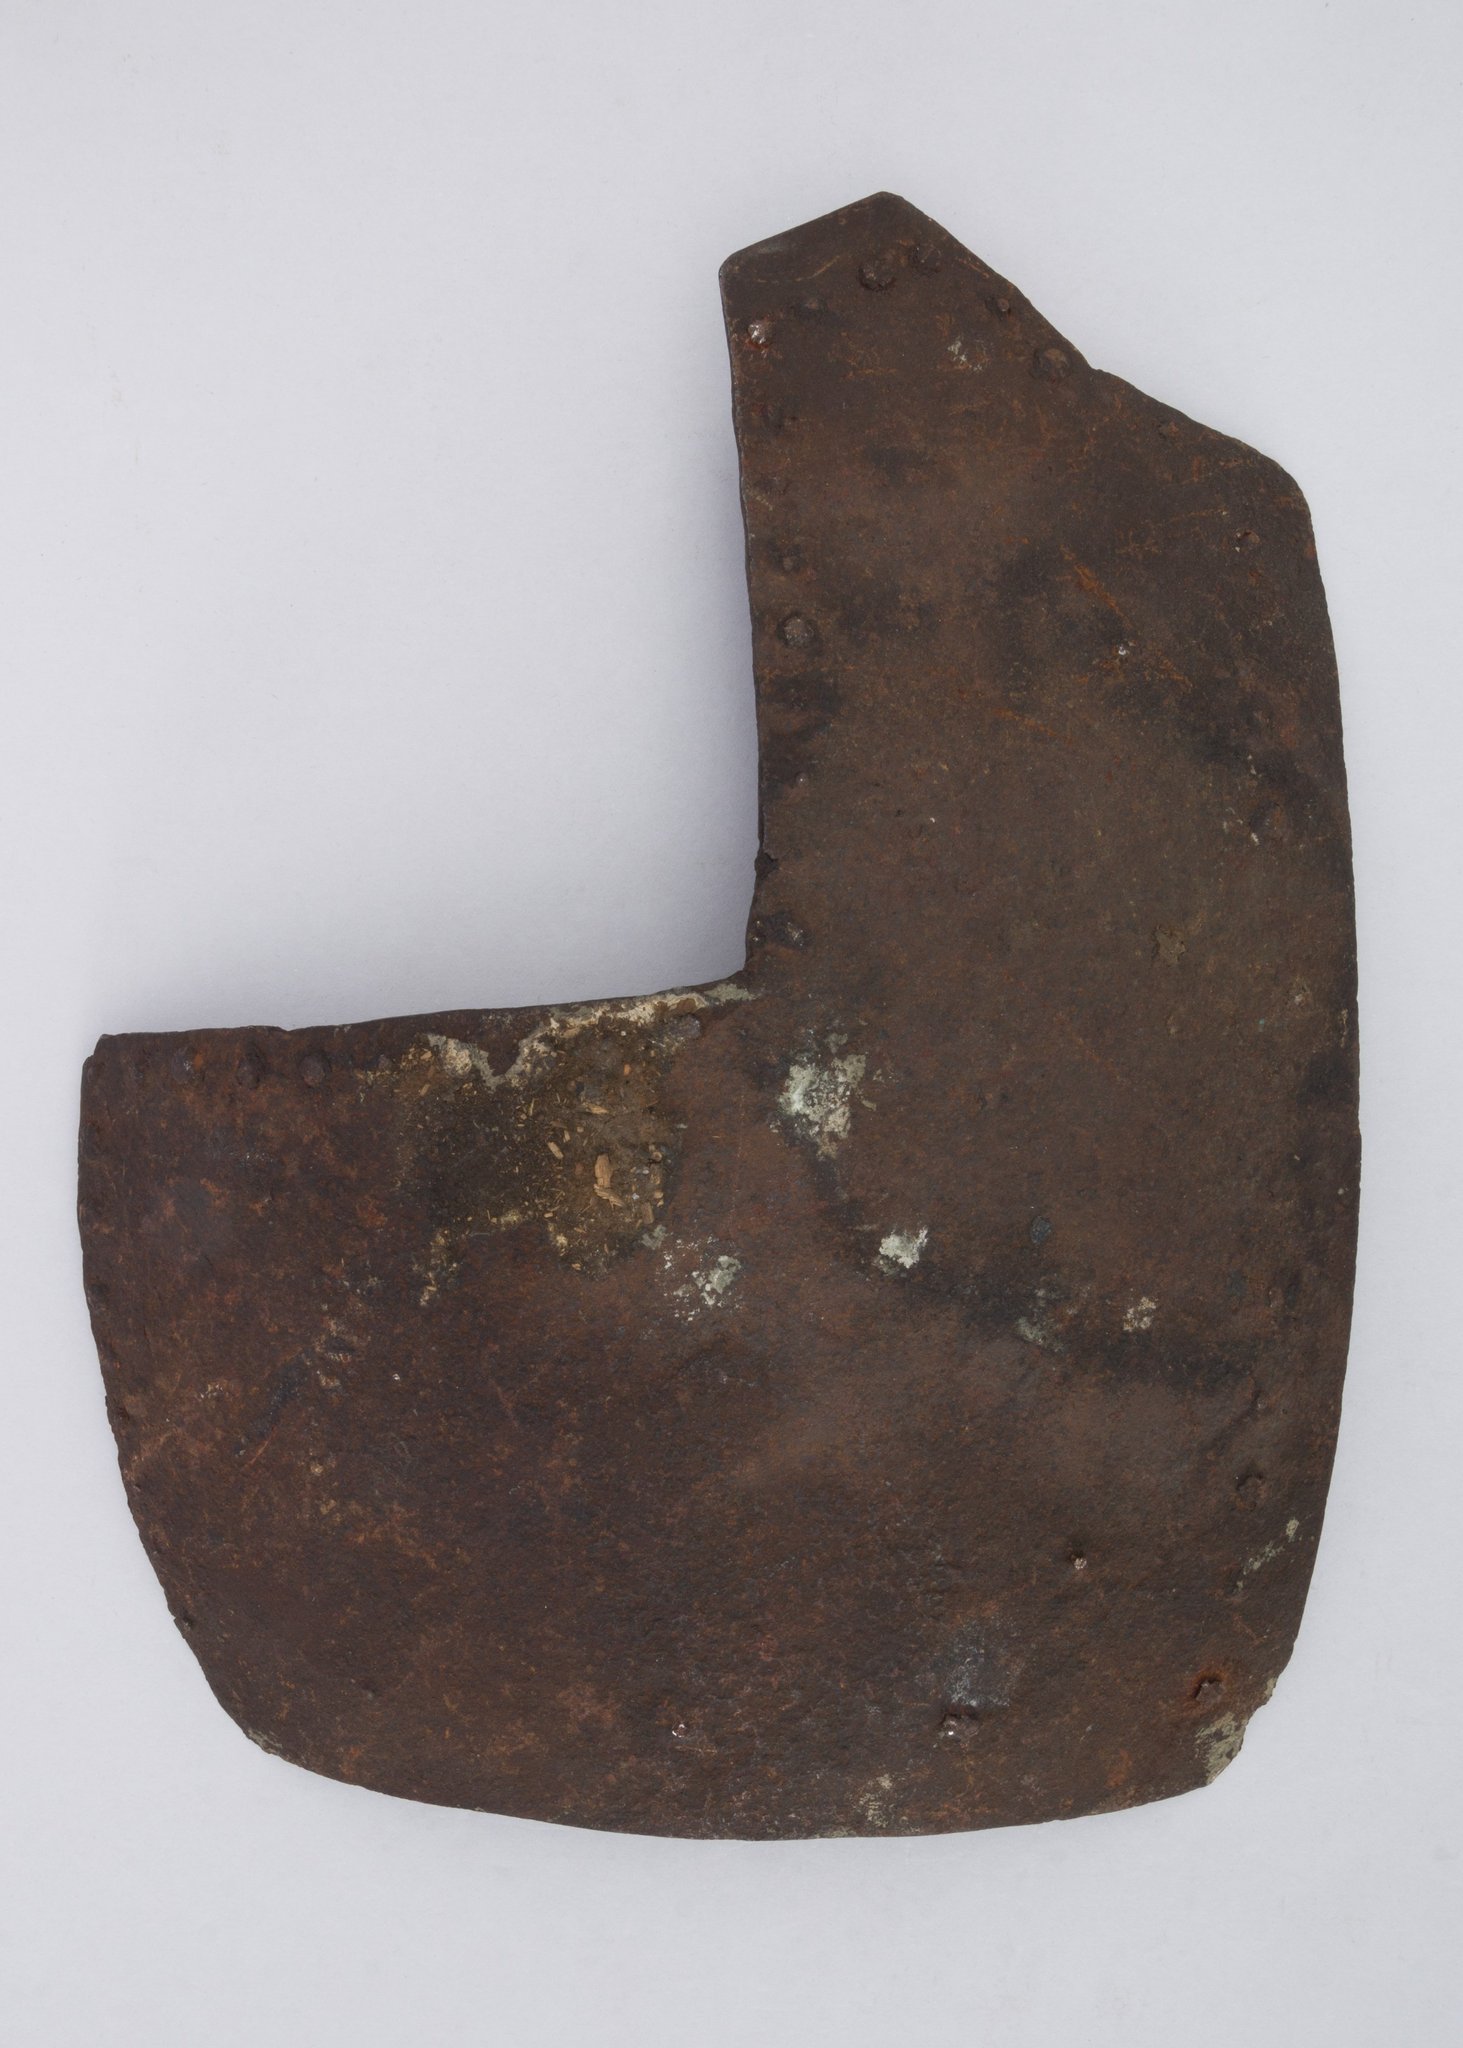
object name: brigandine plate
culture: italian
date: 1400-1450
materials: metal alloy, textile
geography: italy